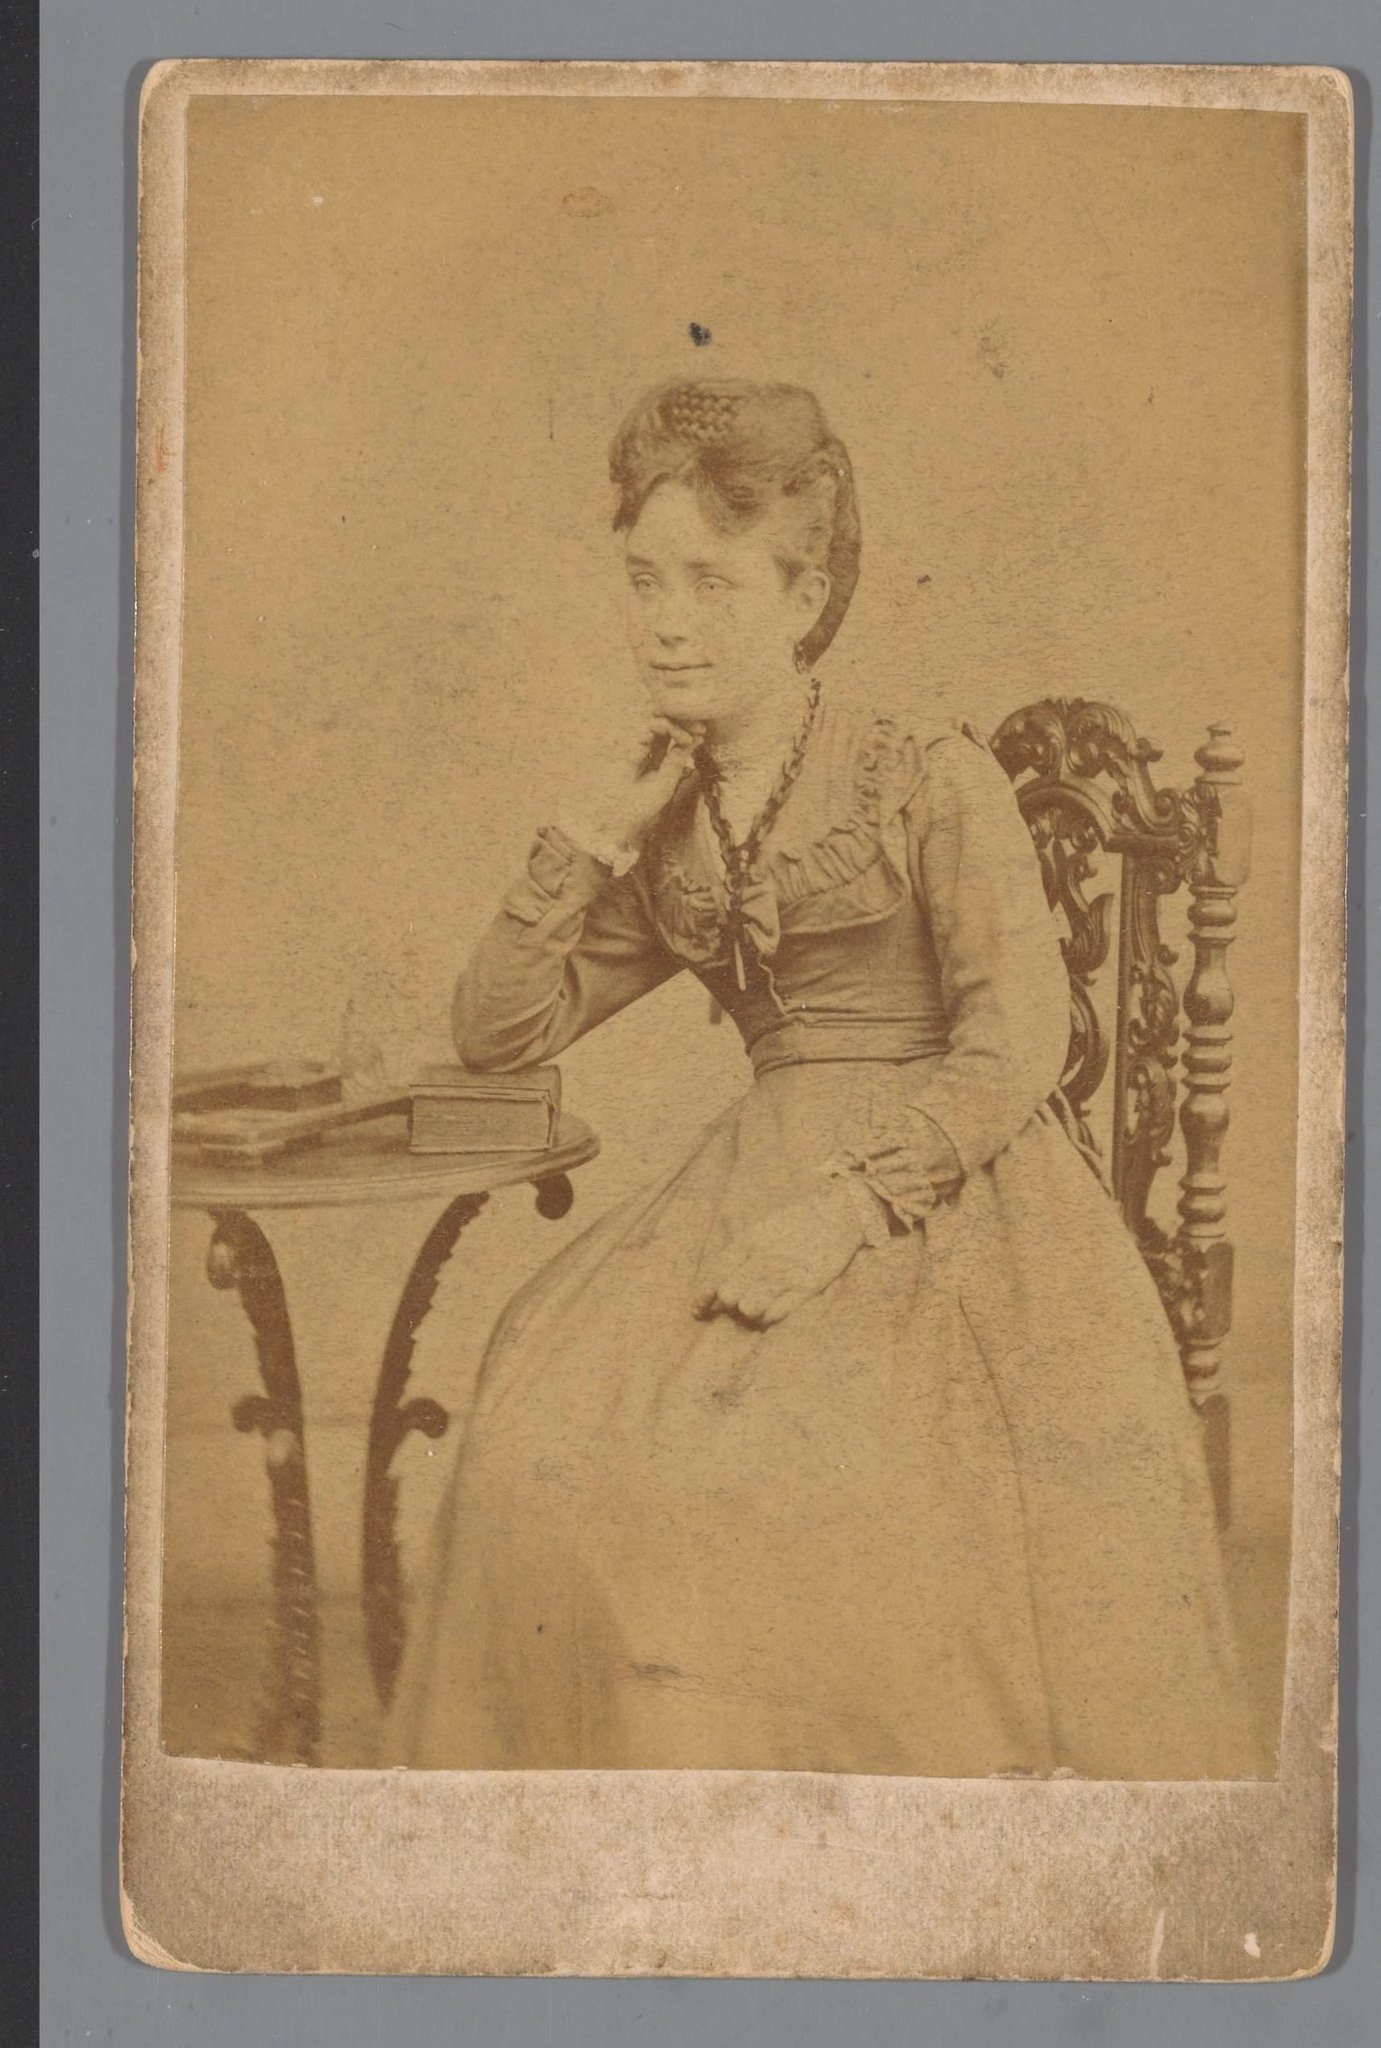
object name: carte de visite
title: Portret van een vrouw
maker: alexander lamont henderson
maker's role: fotograaf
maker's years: 1838-1907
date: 1884-1887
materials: cardboard, paper, photographic support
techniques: albumen print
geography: london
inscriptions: annotation: ‘Copies of this Picture may be hade at any time/by sending the Name Number & Postage Stamp/1 Copy 1/......Negative No’, address: ‘A.L. Henderson/by appointment to the queen/Special First Class Silver Medal Awarded/49, King William St/London Bridge/and at 2, Devonshire Place/ Amersham Road/New Cross/Artist’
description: Zittende vrouw met haar hand onder haar kin en haar elleboog steunend op een boek dat op het tafeltje naast haar ligt.